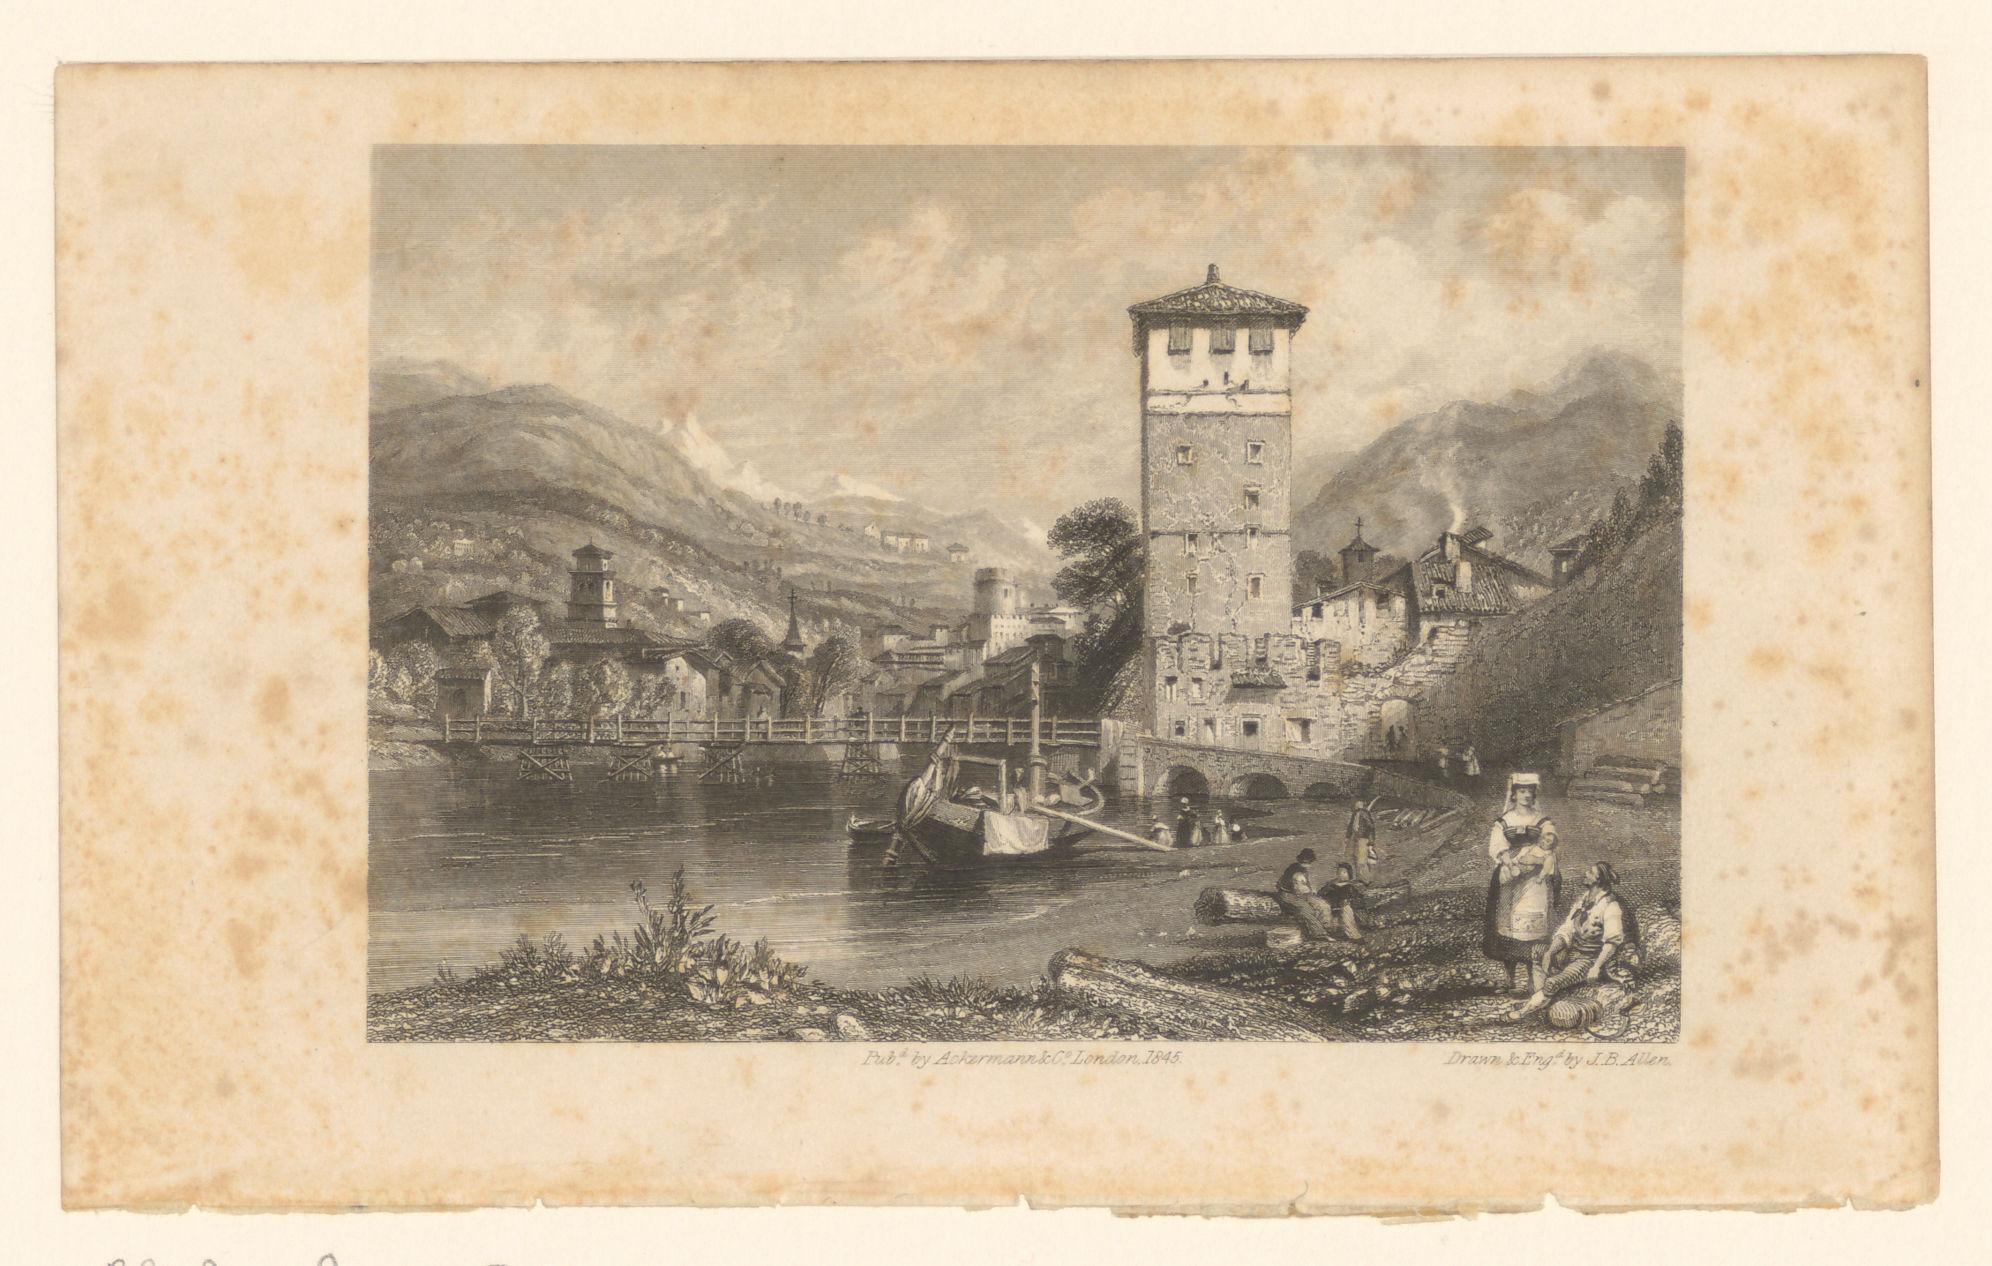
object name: print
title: Gezicht op een dorp in een dal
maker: james baylie allen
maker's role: print maker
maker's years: 1803-1876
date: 1845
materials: paper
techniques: engraving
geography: england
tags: prospect of village, silhouette of village, lake (+ landscape with figures, staffage), mountains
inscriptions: collector's mark: Lugt 2228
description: Gezicht op een dorp, mogelijk in Noord-Italië.